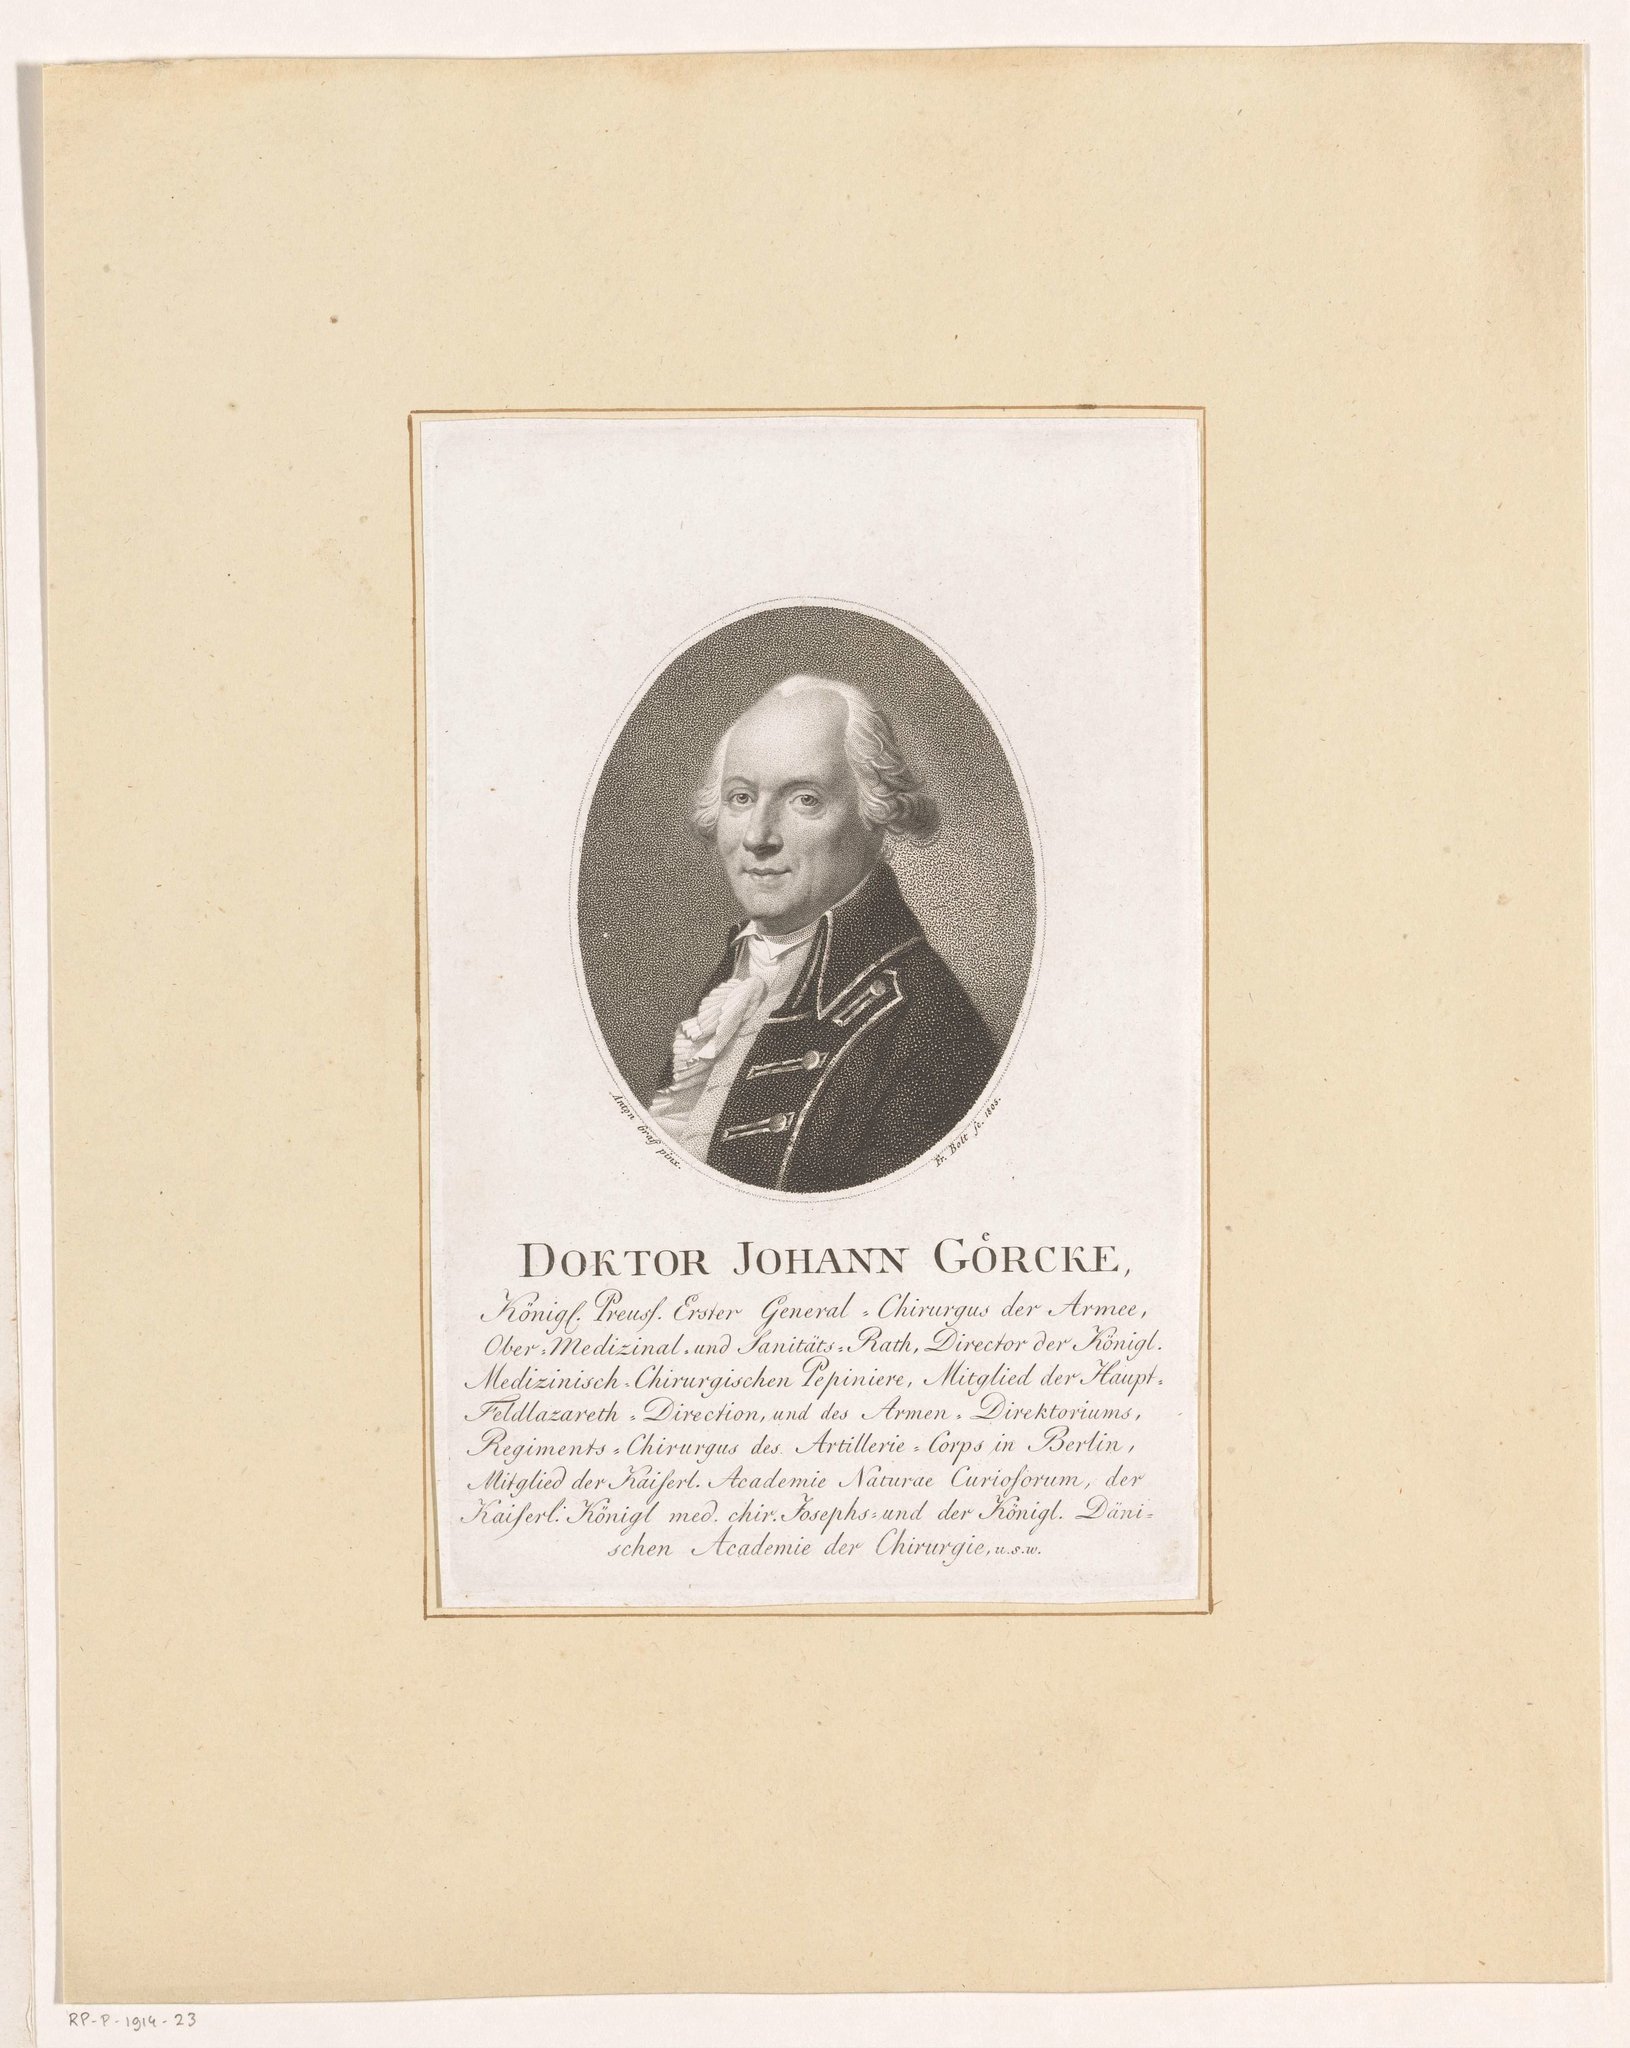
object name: calendar leaf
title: Kalenderblad januari met ijsvogel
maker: theo van hoytema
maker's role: draughtsman, painter, print maker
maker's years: 1863-1917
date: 1903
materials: paper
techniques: lithograph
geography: amsterdam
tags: full moon represented as face, aquarius (zodiacal sign of january), january ~ other concepts, other birds: kingfisher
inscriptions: collector's mark: Lugt 2228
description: Onder de data een volle maan en het sterrenbeeld Waterman. Onder het jaartal een scheurlijn.